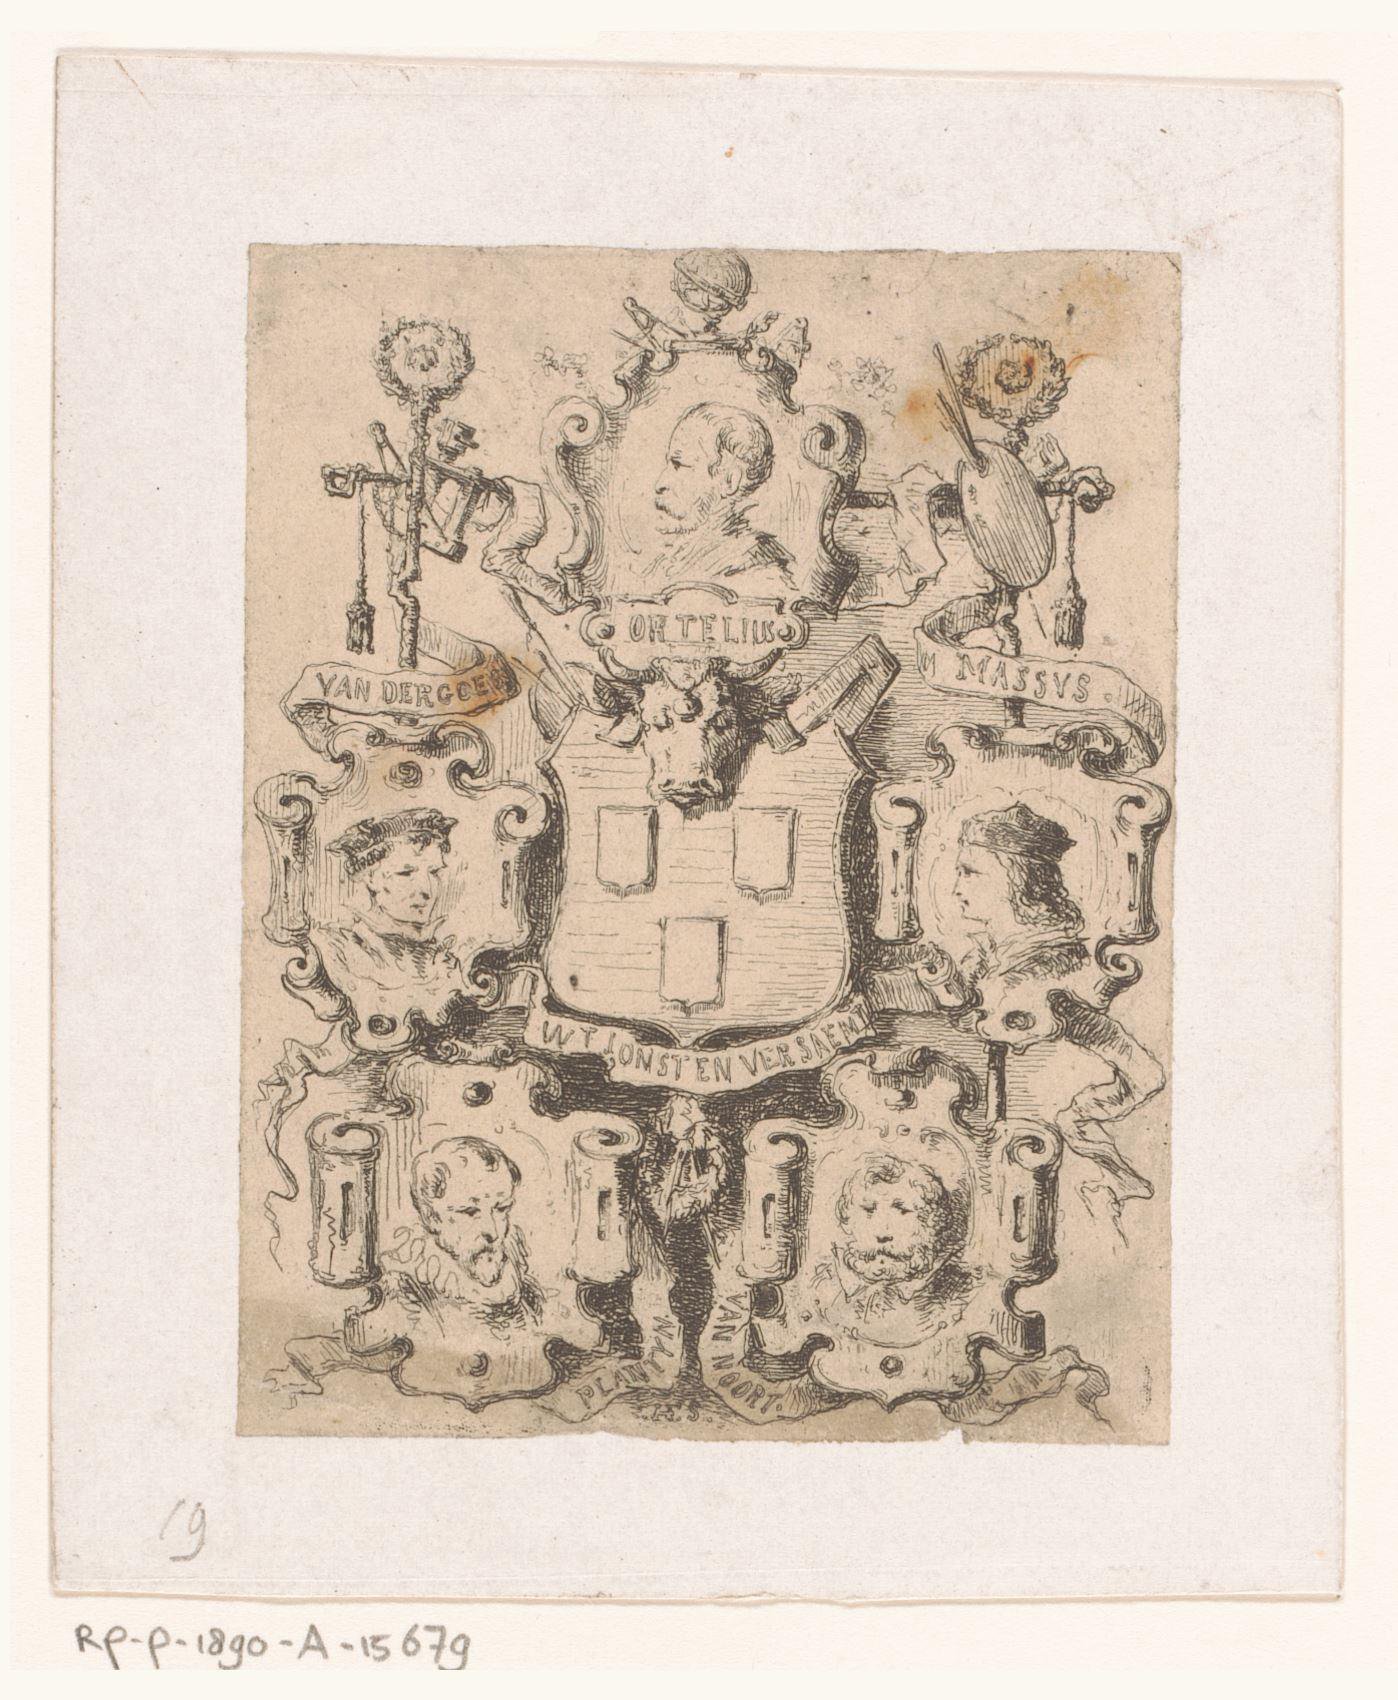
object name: print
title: Wapen van het Sint-Lucasgilde met rondom vijf portretten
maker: henri françois schaefels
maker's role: print maker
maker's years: 1827-1904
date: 1837-1888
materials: paper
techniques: etching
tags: christoffel plantijn, ghent, brussels, hugo van der goes, antwerp, abraham ortelius, quinten massijs (i), draughtsman, lambert van noort, historical persons, coat of arms of guild of st. luke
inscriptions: collector's mark: Lugt 2228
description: De portretten zijn van: Abraham Ortelius, Quinten Massijs, Lambert van Noort, Christoffel Plantijn en Hugo van der Goes.